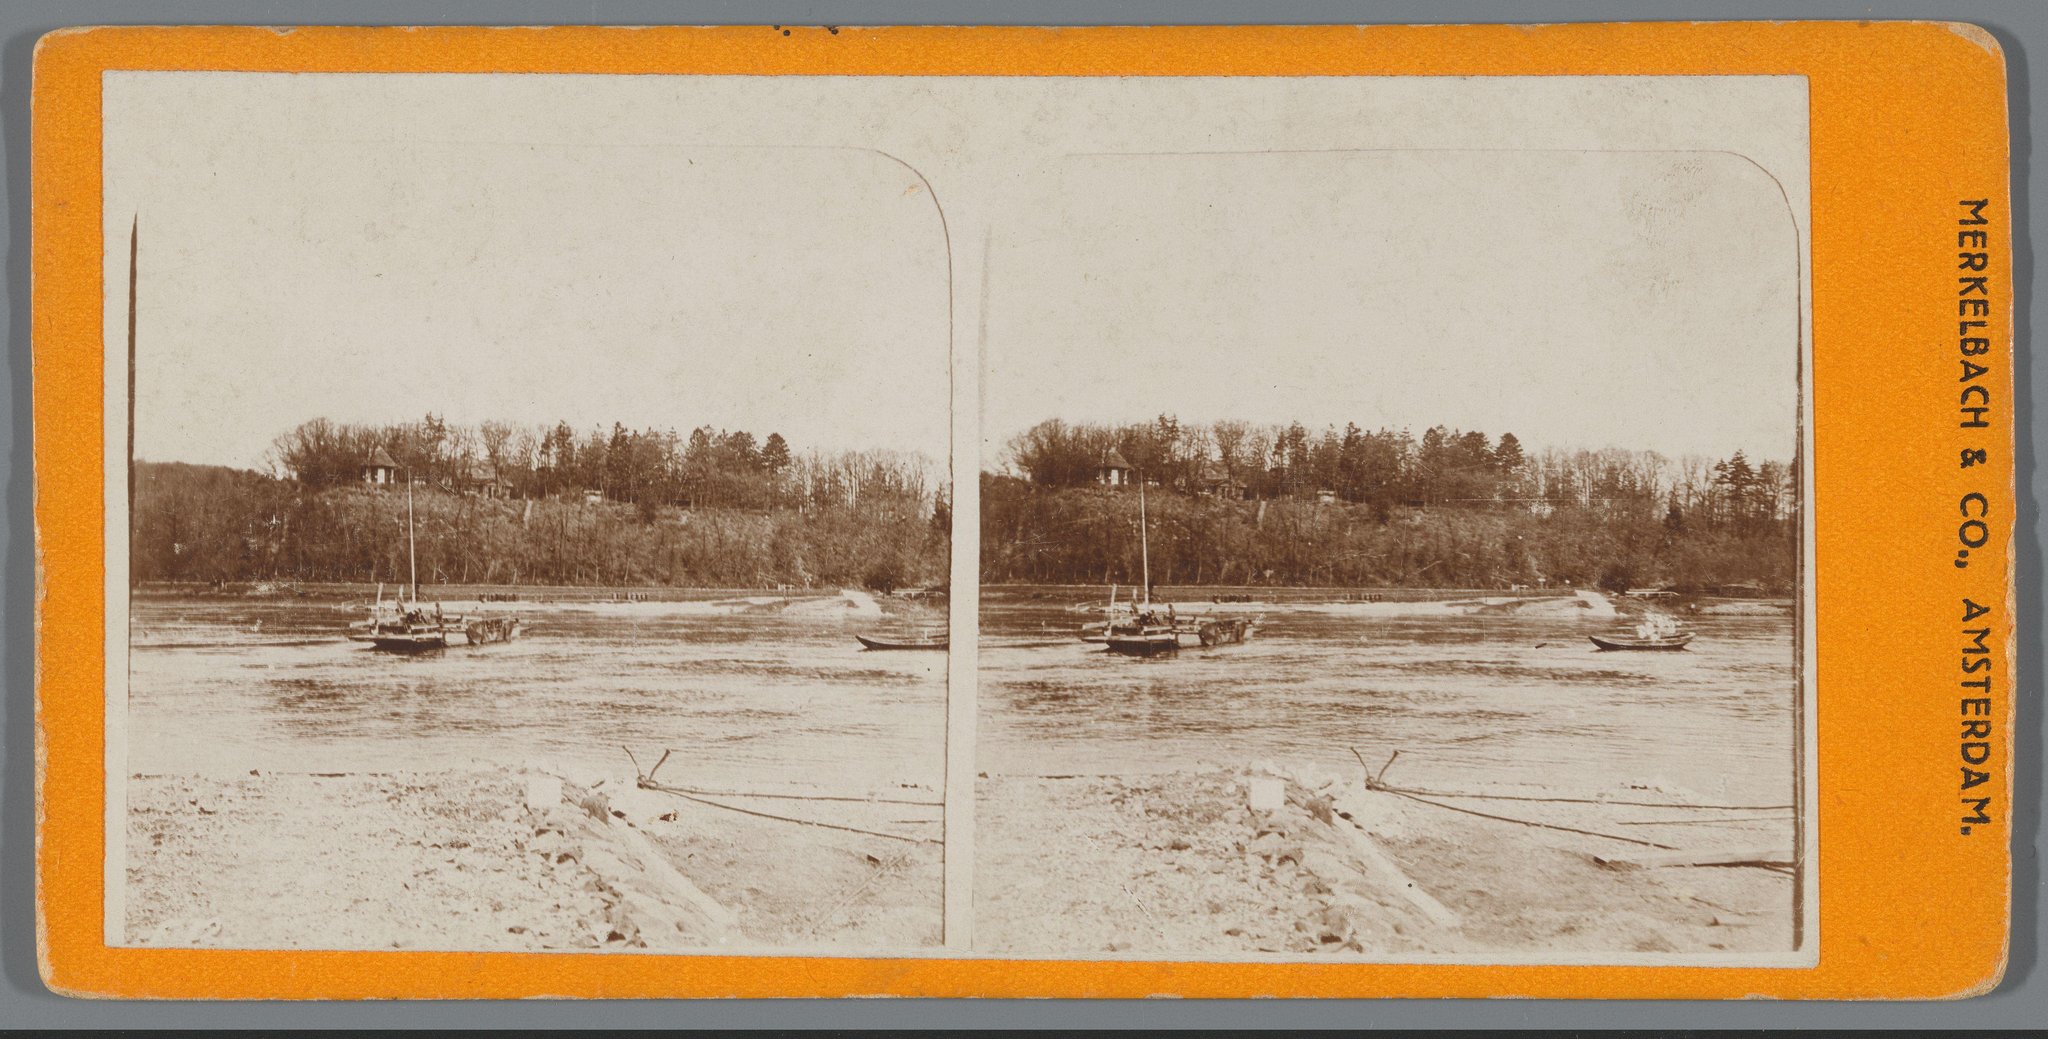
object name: stereograph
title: Westerbouwing, Nederland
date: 1905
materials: paper, cardboard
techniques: collodion silver print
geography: amsterdam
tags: westerbouwing